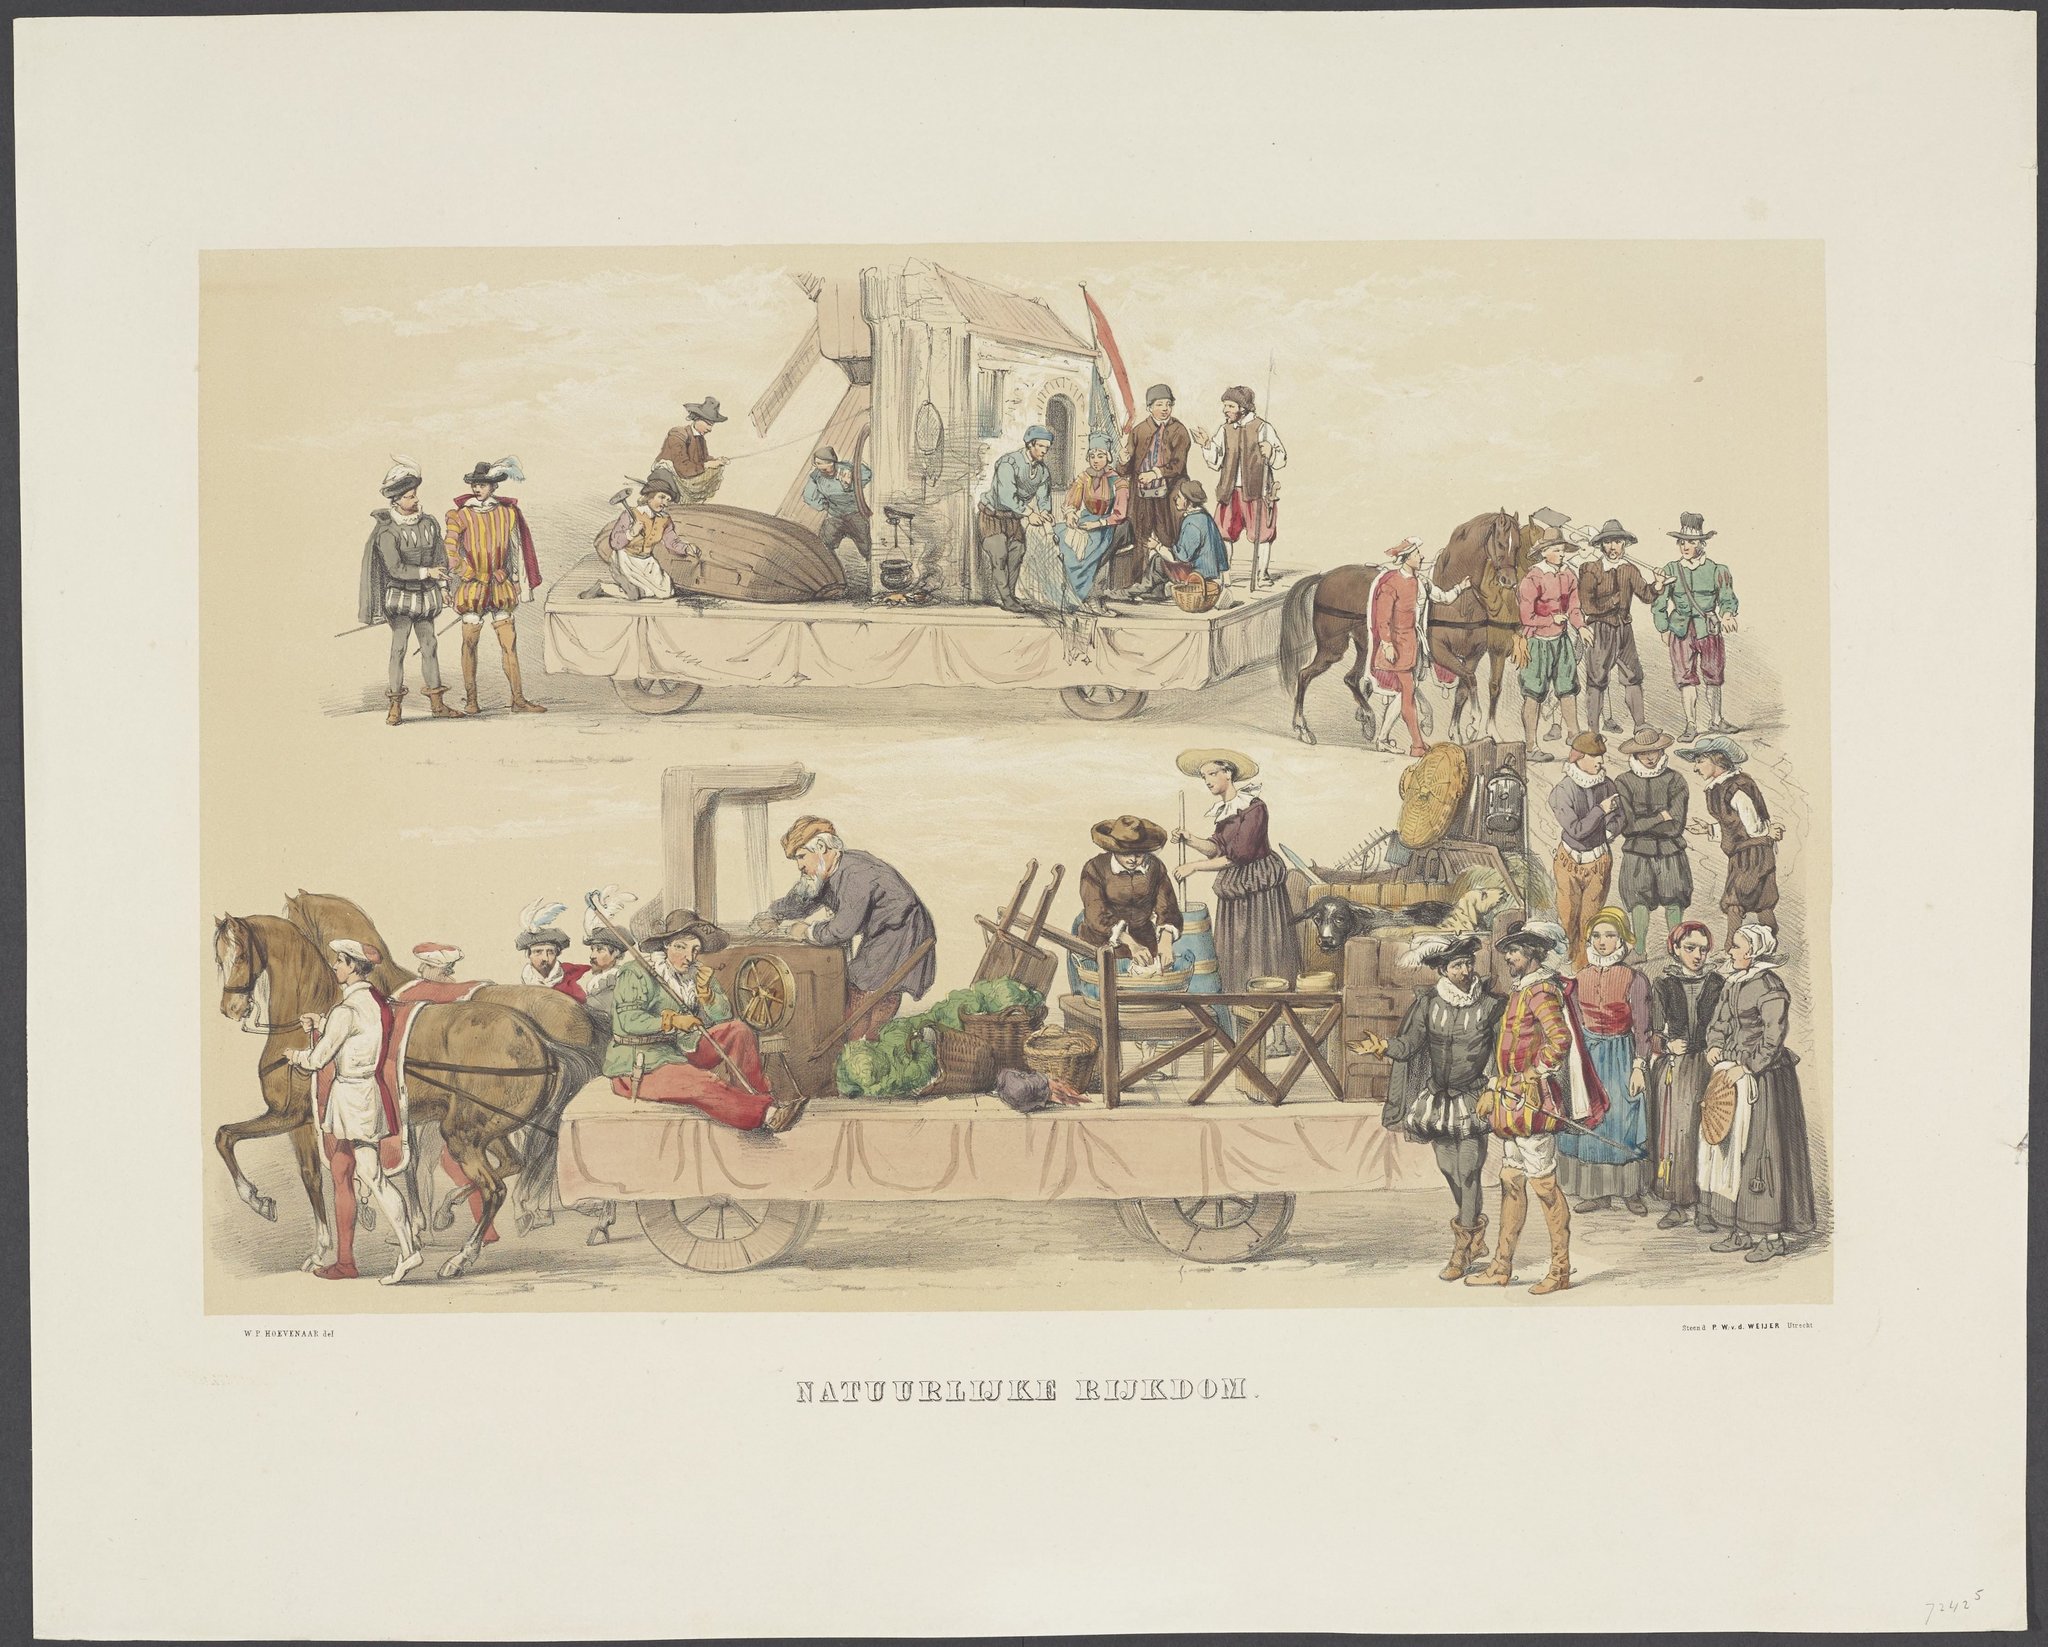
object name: print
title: Ons vaderland omstreeks het midden der 17e eeuw, voorgesteld door H.H. studenten, leden van Mutua Fides, ter viering van het 220jarig bestaan der Utrechtsche Hoogeschool, den 25. Junij 1856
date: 1856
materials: paper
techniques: hand coloring, lithograph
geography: utrecht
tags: students' pageant, costumes used in pageants, dutch east indies, the, utrecht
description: Twee praalwagens met uitbeeldingen van Nederlandse melkproductie, textielproductie, visserij en houtbewerking. Onderdeel van de groep van zeven platen met verklaring van de historische optocht in maskerade opgevoerd door de studenten van de vereniging Mutua Fides van de Utrechtse Hogeschool op 25 juni 1856 ter gelegenheid van de viering van haar 220-jarige bestaan.